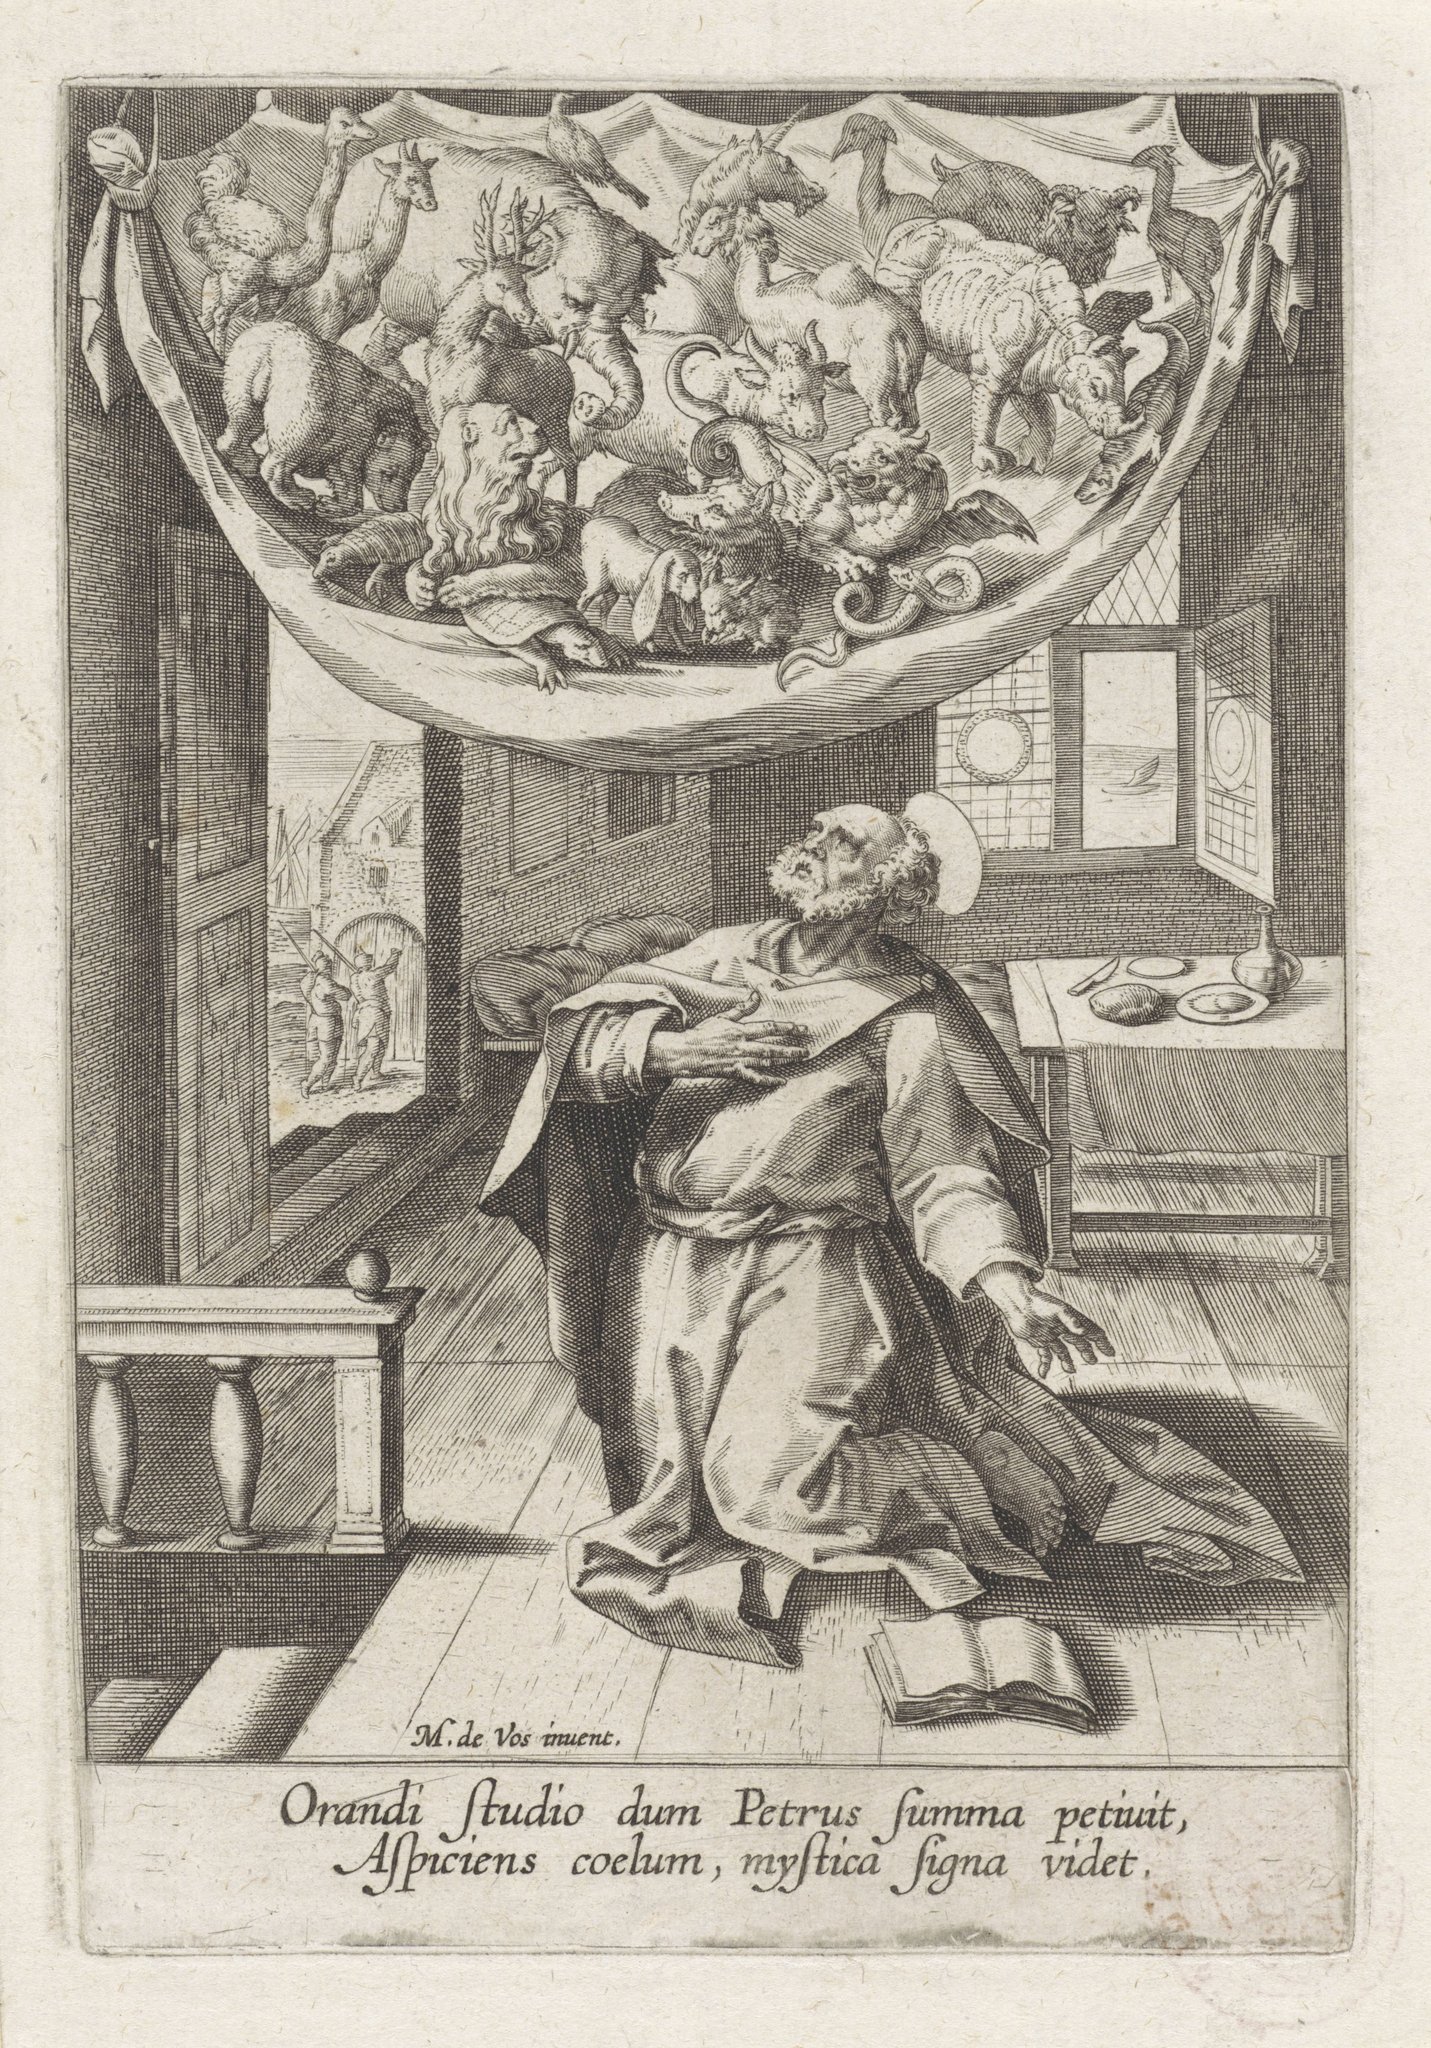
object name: print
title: Handelingen van de apostelen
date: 1591-1600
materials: paper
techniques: engraving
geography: antwerp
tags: peter's vision of the unclean beasts on the roof of the house of simon the tanner: a sheet descends from heaven full of four-footed beasts, creeping things and fowl of the air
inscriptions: collector's mark: Lugt 240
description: Simon bidt in het huis van Simon de leerlooier. Boven hem verschijnt een laken met allerlei onreine diersoorten. Hij kreeg drie keer het bevel om de dieren te slachten en op te eten, maar dat weigerde hij. Onder in de marge een tweeregelig onderschrift in het Latijn.